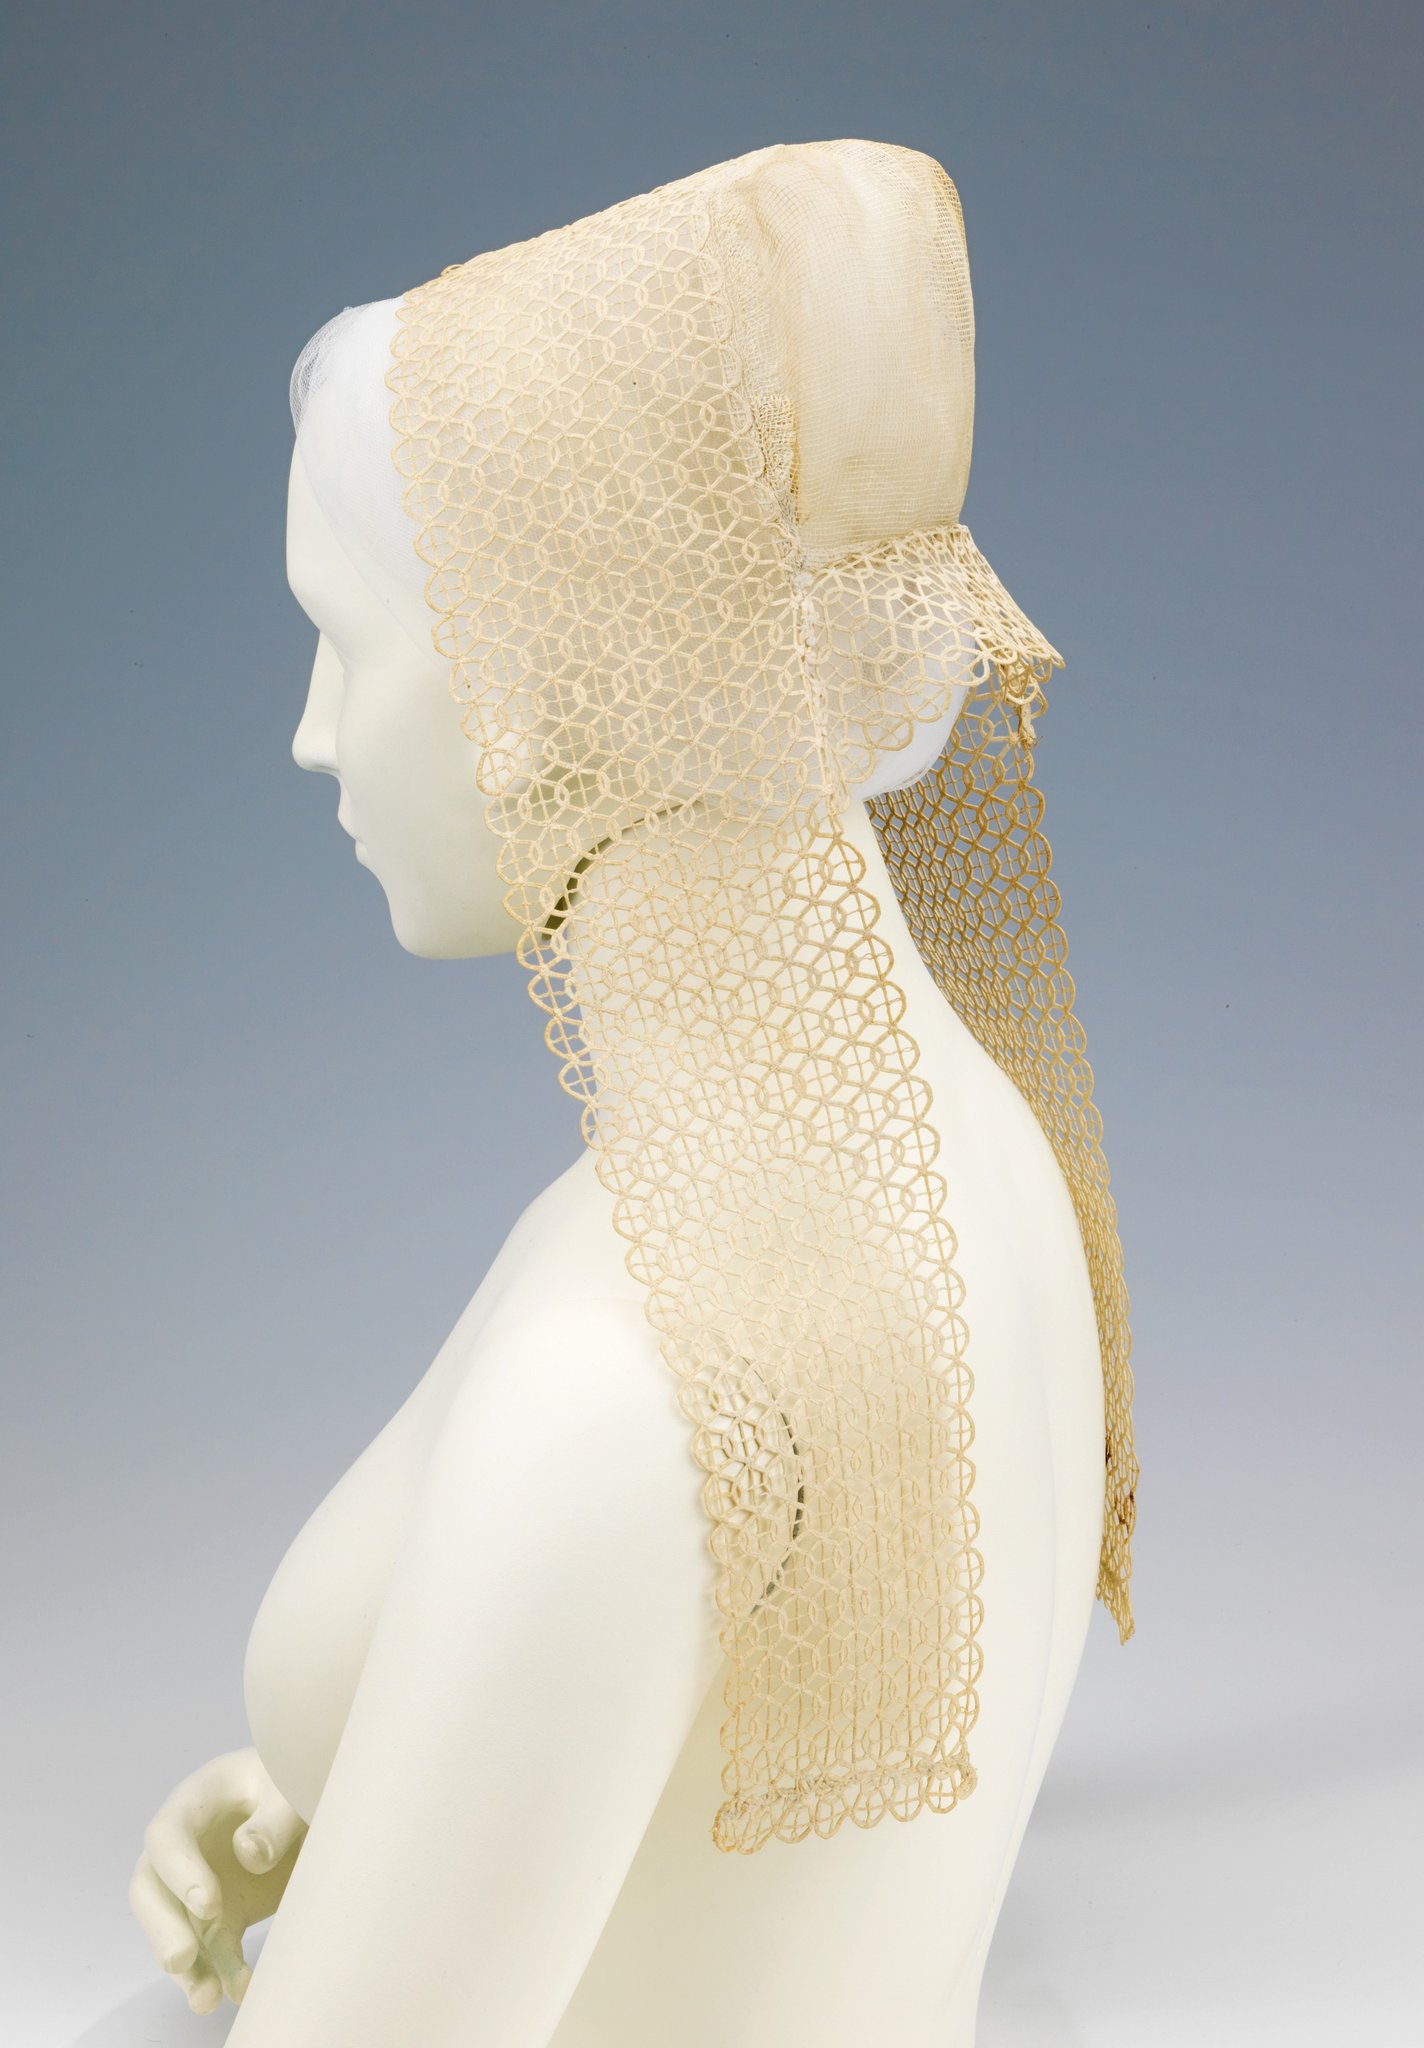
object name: cap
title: Breton Woman's Coif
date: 1890-1910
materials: linen